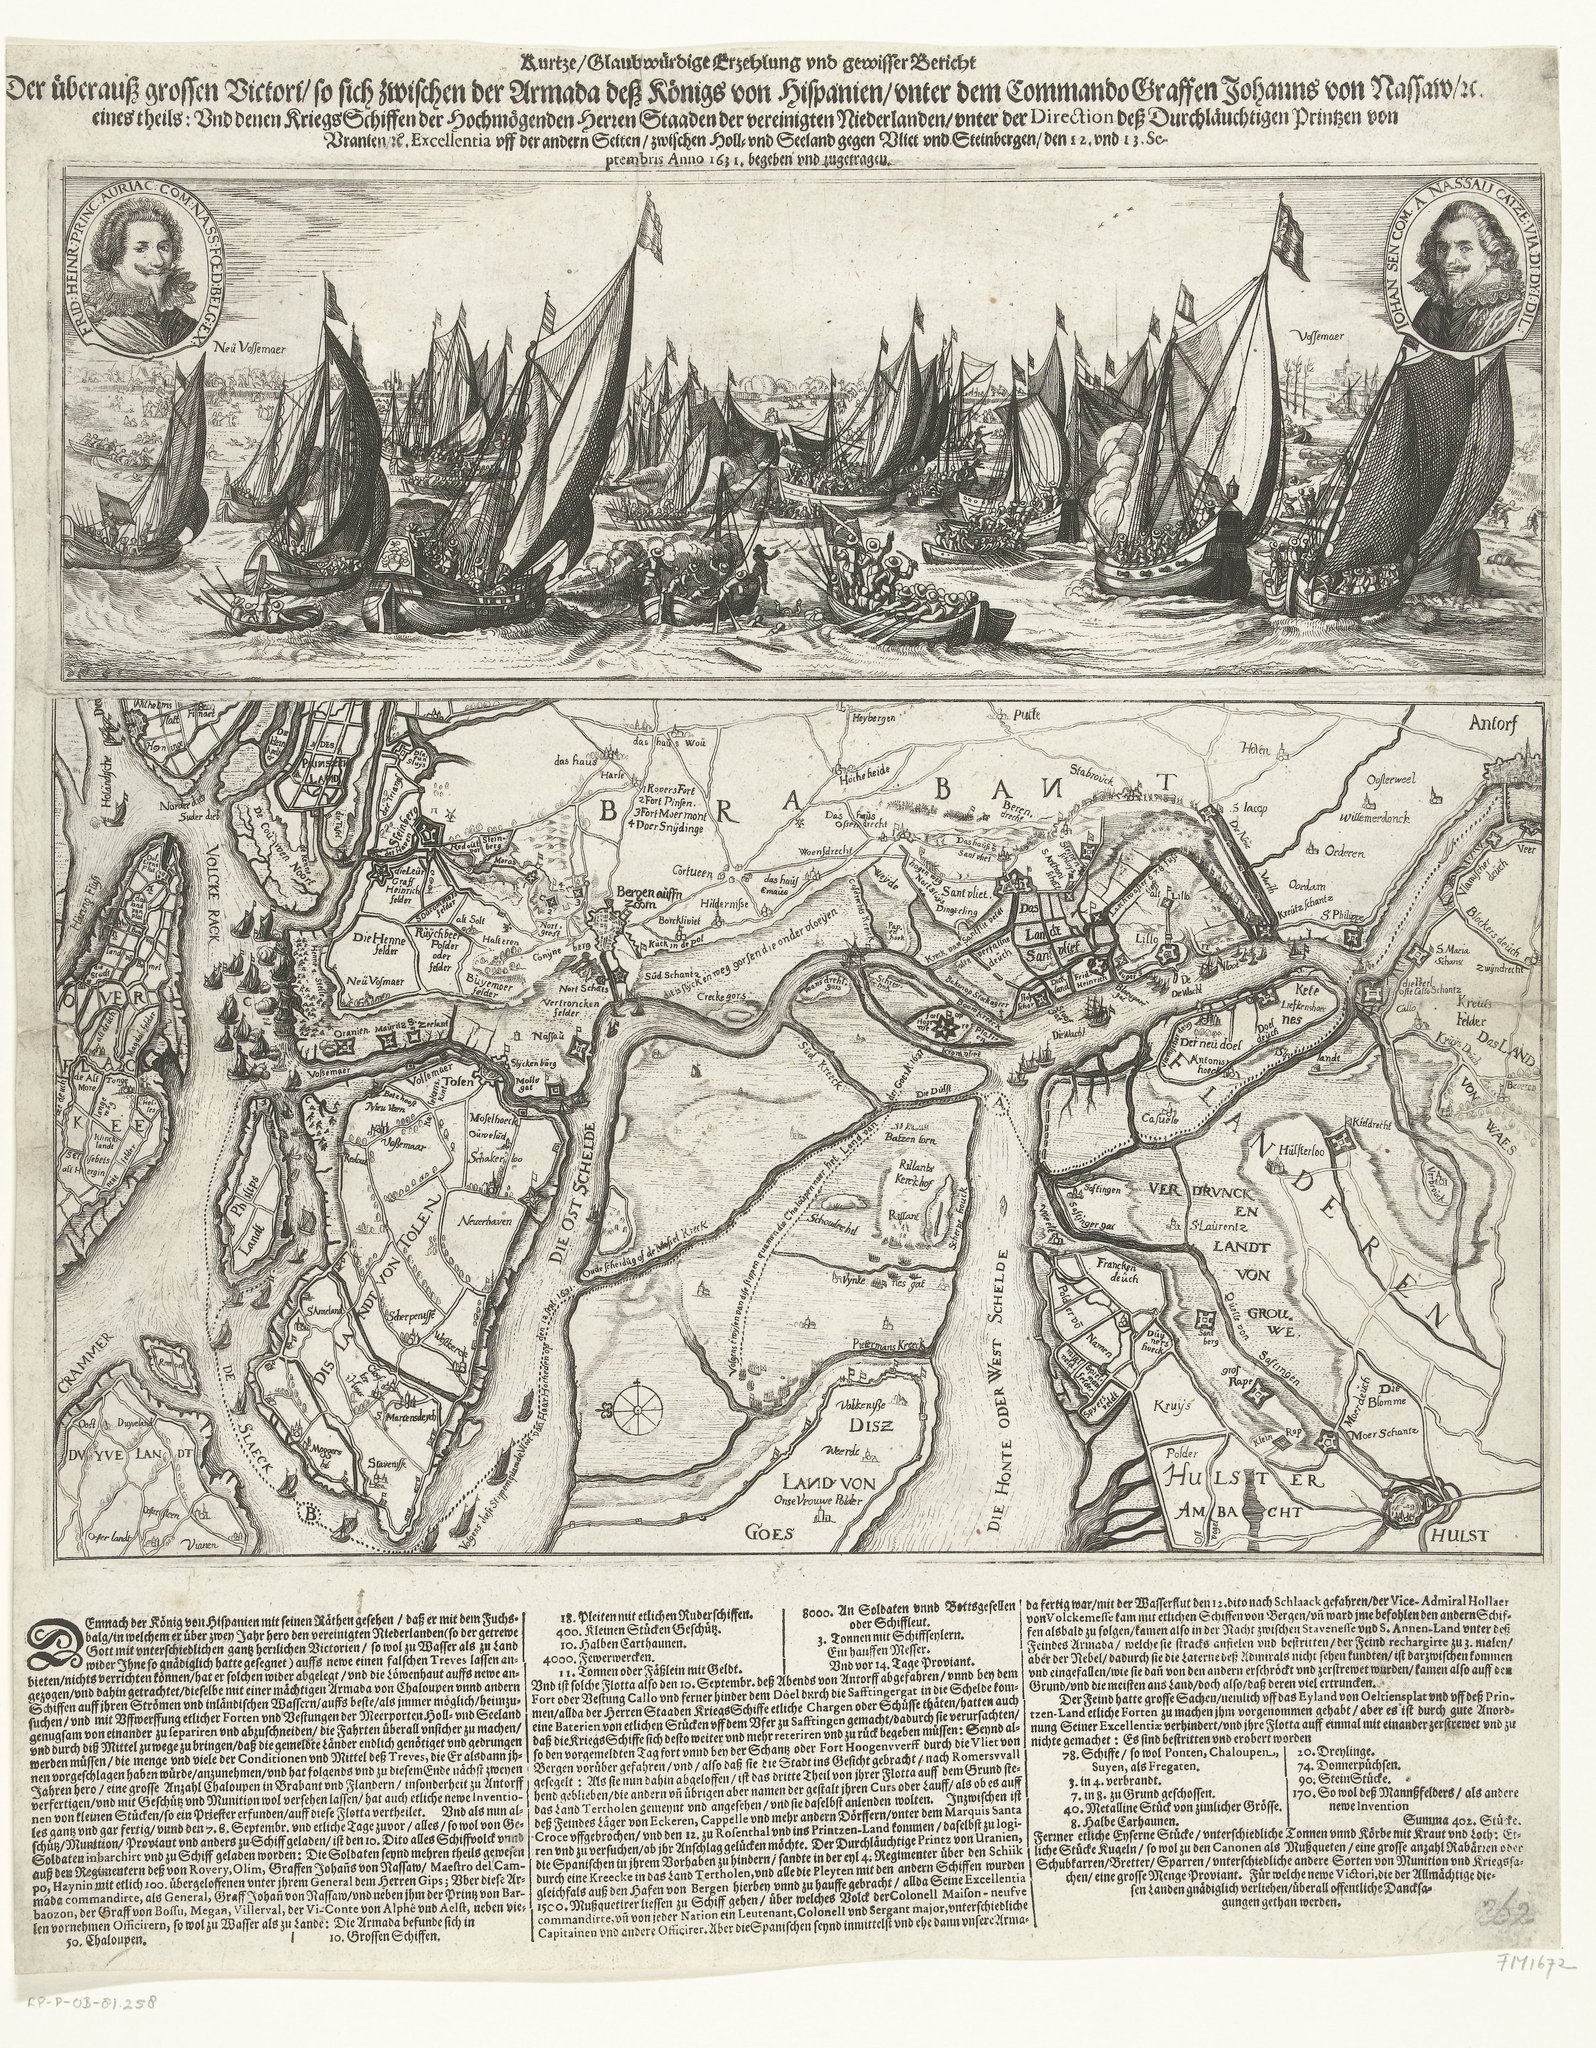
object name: print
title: Kurtze / Glaubwurdige Erzehlung und gewisser Bericht Der uberauss grossen Victori / so sich zwischen der Armada dess Königs von Hispanien / unter dem Commando Graffen Johanns von Nassaw (...) Und denen KriegsSchiffen der Hochmögenden Herren Staaden der vereinigten Niederlanden (...)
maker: Anonymous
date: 1631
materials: paper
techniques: etching, letterpress printing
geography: germany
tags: delft, frederick henry (prince of orange), maps of separate countries or regions, battle (+ naval force)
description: De slag op het Slaak, 12-13 september 1631. Plaat met twee voorstellingen. Onder een kaart van de waterwegen, kreken en ondergelopen land tussen Hulst, Antwerpen en Bergen op Zoom. Op de kaart zijn de vaarroutes aangegeven die de Staatse en Spaanse vloten namen voor de slag op het Slaak. Boven een voorstelling van de zeeslag met portretten van Frederik Hendrik en graaf Johan VIII van Nassau-Siegen. De Staatse vloot onder bevel van vice-admiraal Marinus Hollare. Onder de plaat is een tekst van 3 kolommen in het Duits gedrukt.